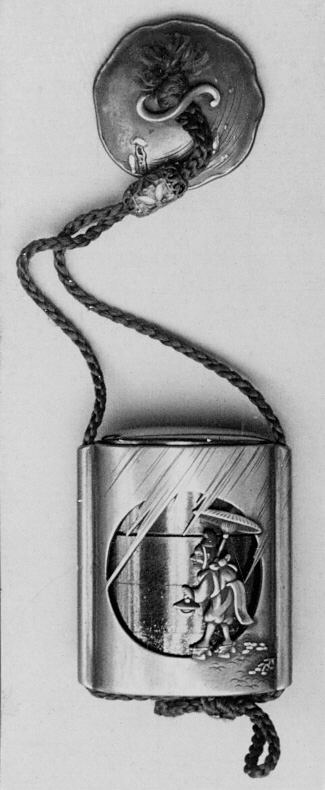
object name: inrō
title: Case (Inrō)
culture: japanese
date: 1801-1900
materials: bronze, metal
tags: human figures